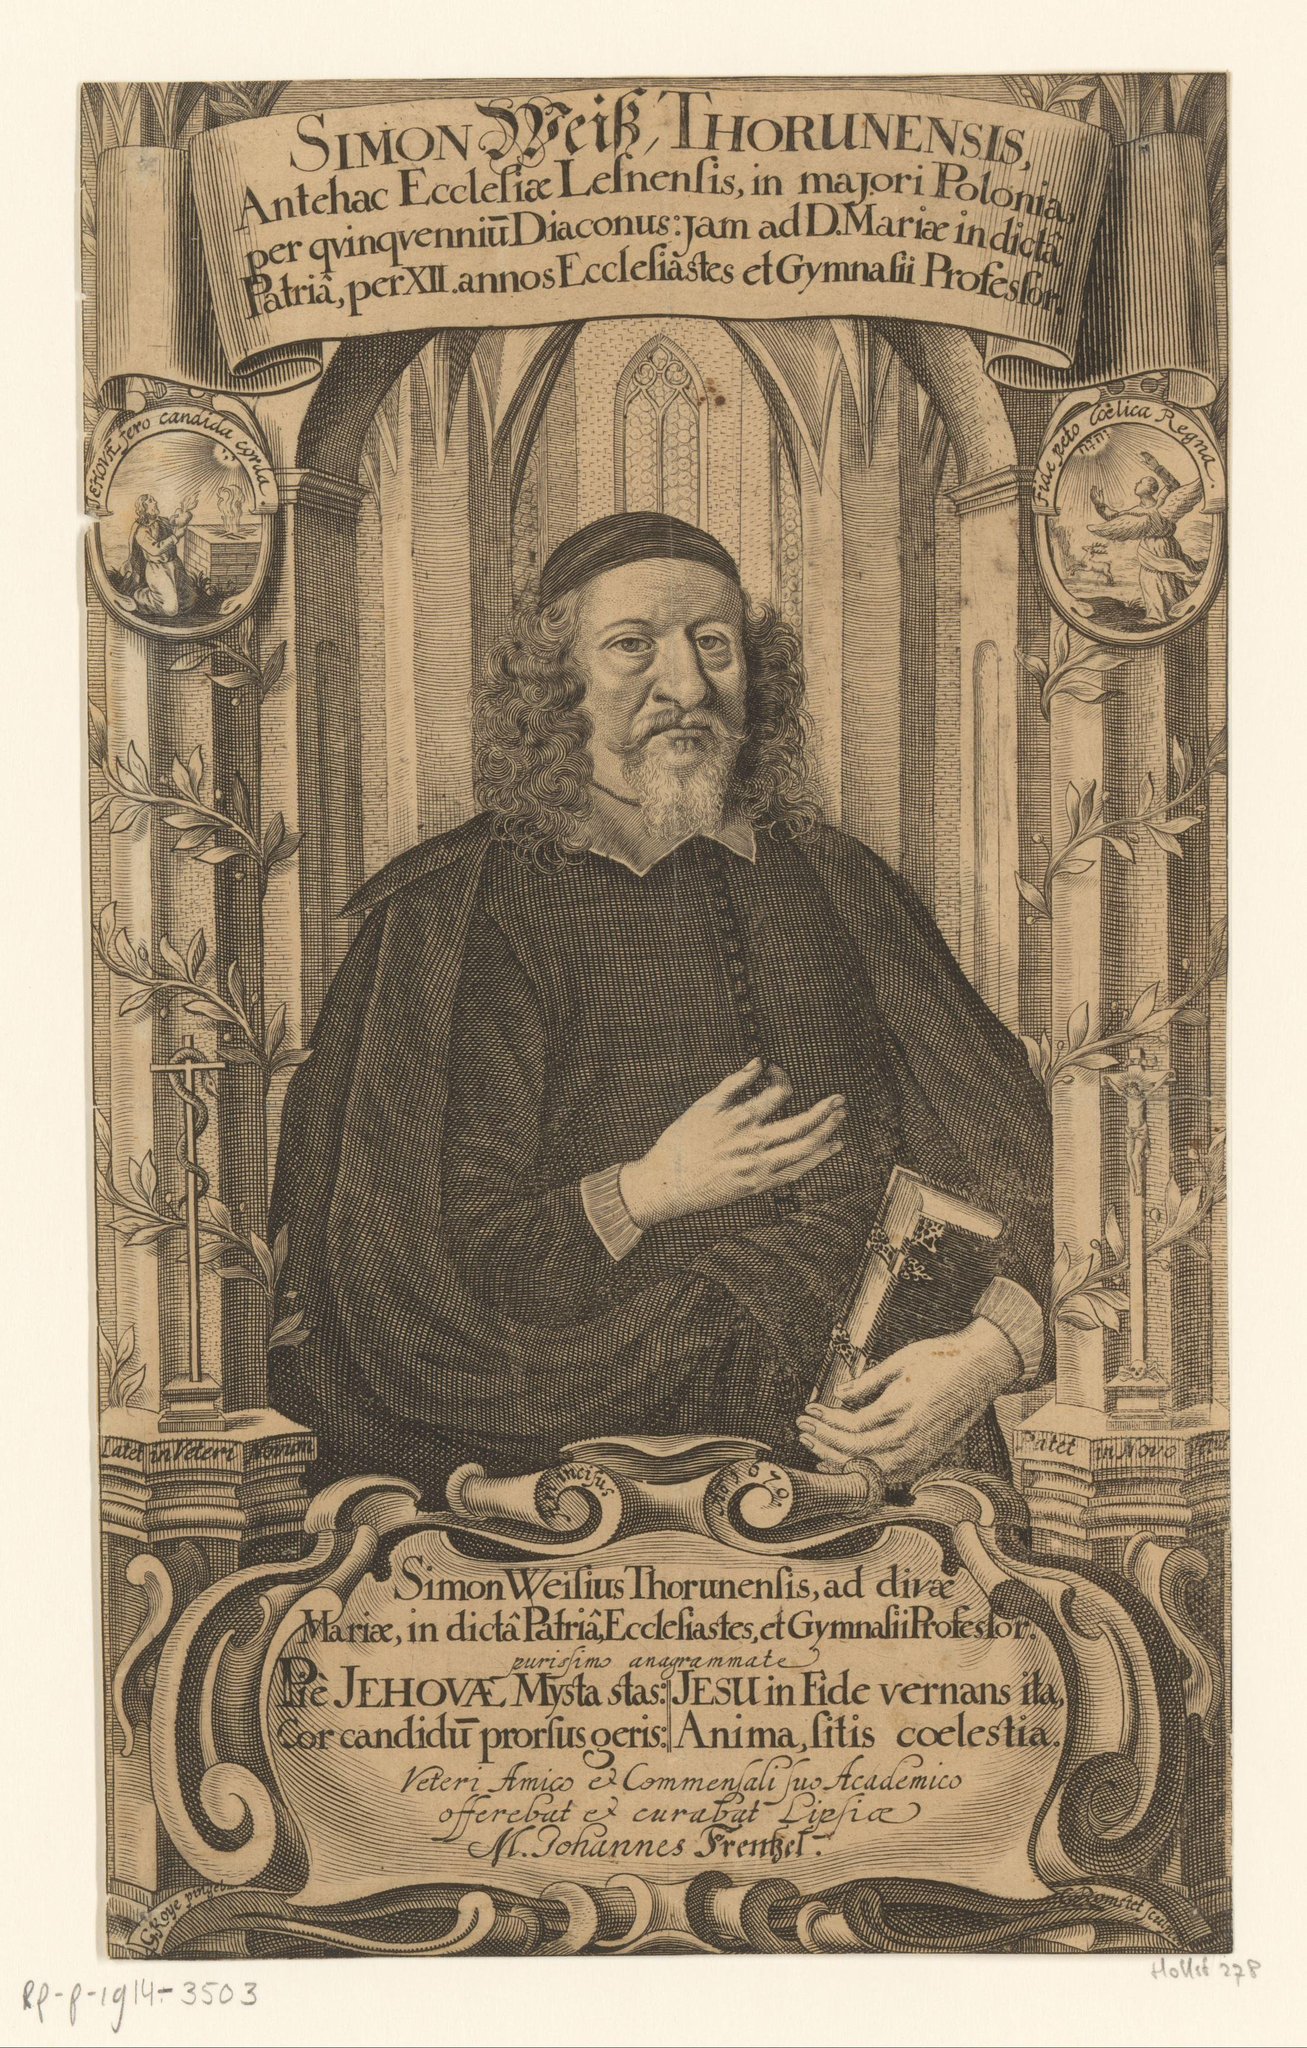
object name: print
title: Portret van Simon Weiss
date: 1665-1721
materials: paper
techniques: engraving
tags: historical persons, interior of church, abstract ideas and concepts (+ emblematical representation of concept), armorial bearing, heraldry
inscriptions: collector's mark: Lugt 2228